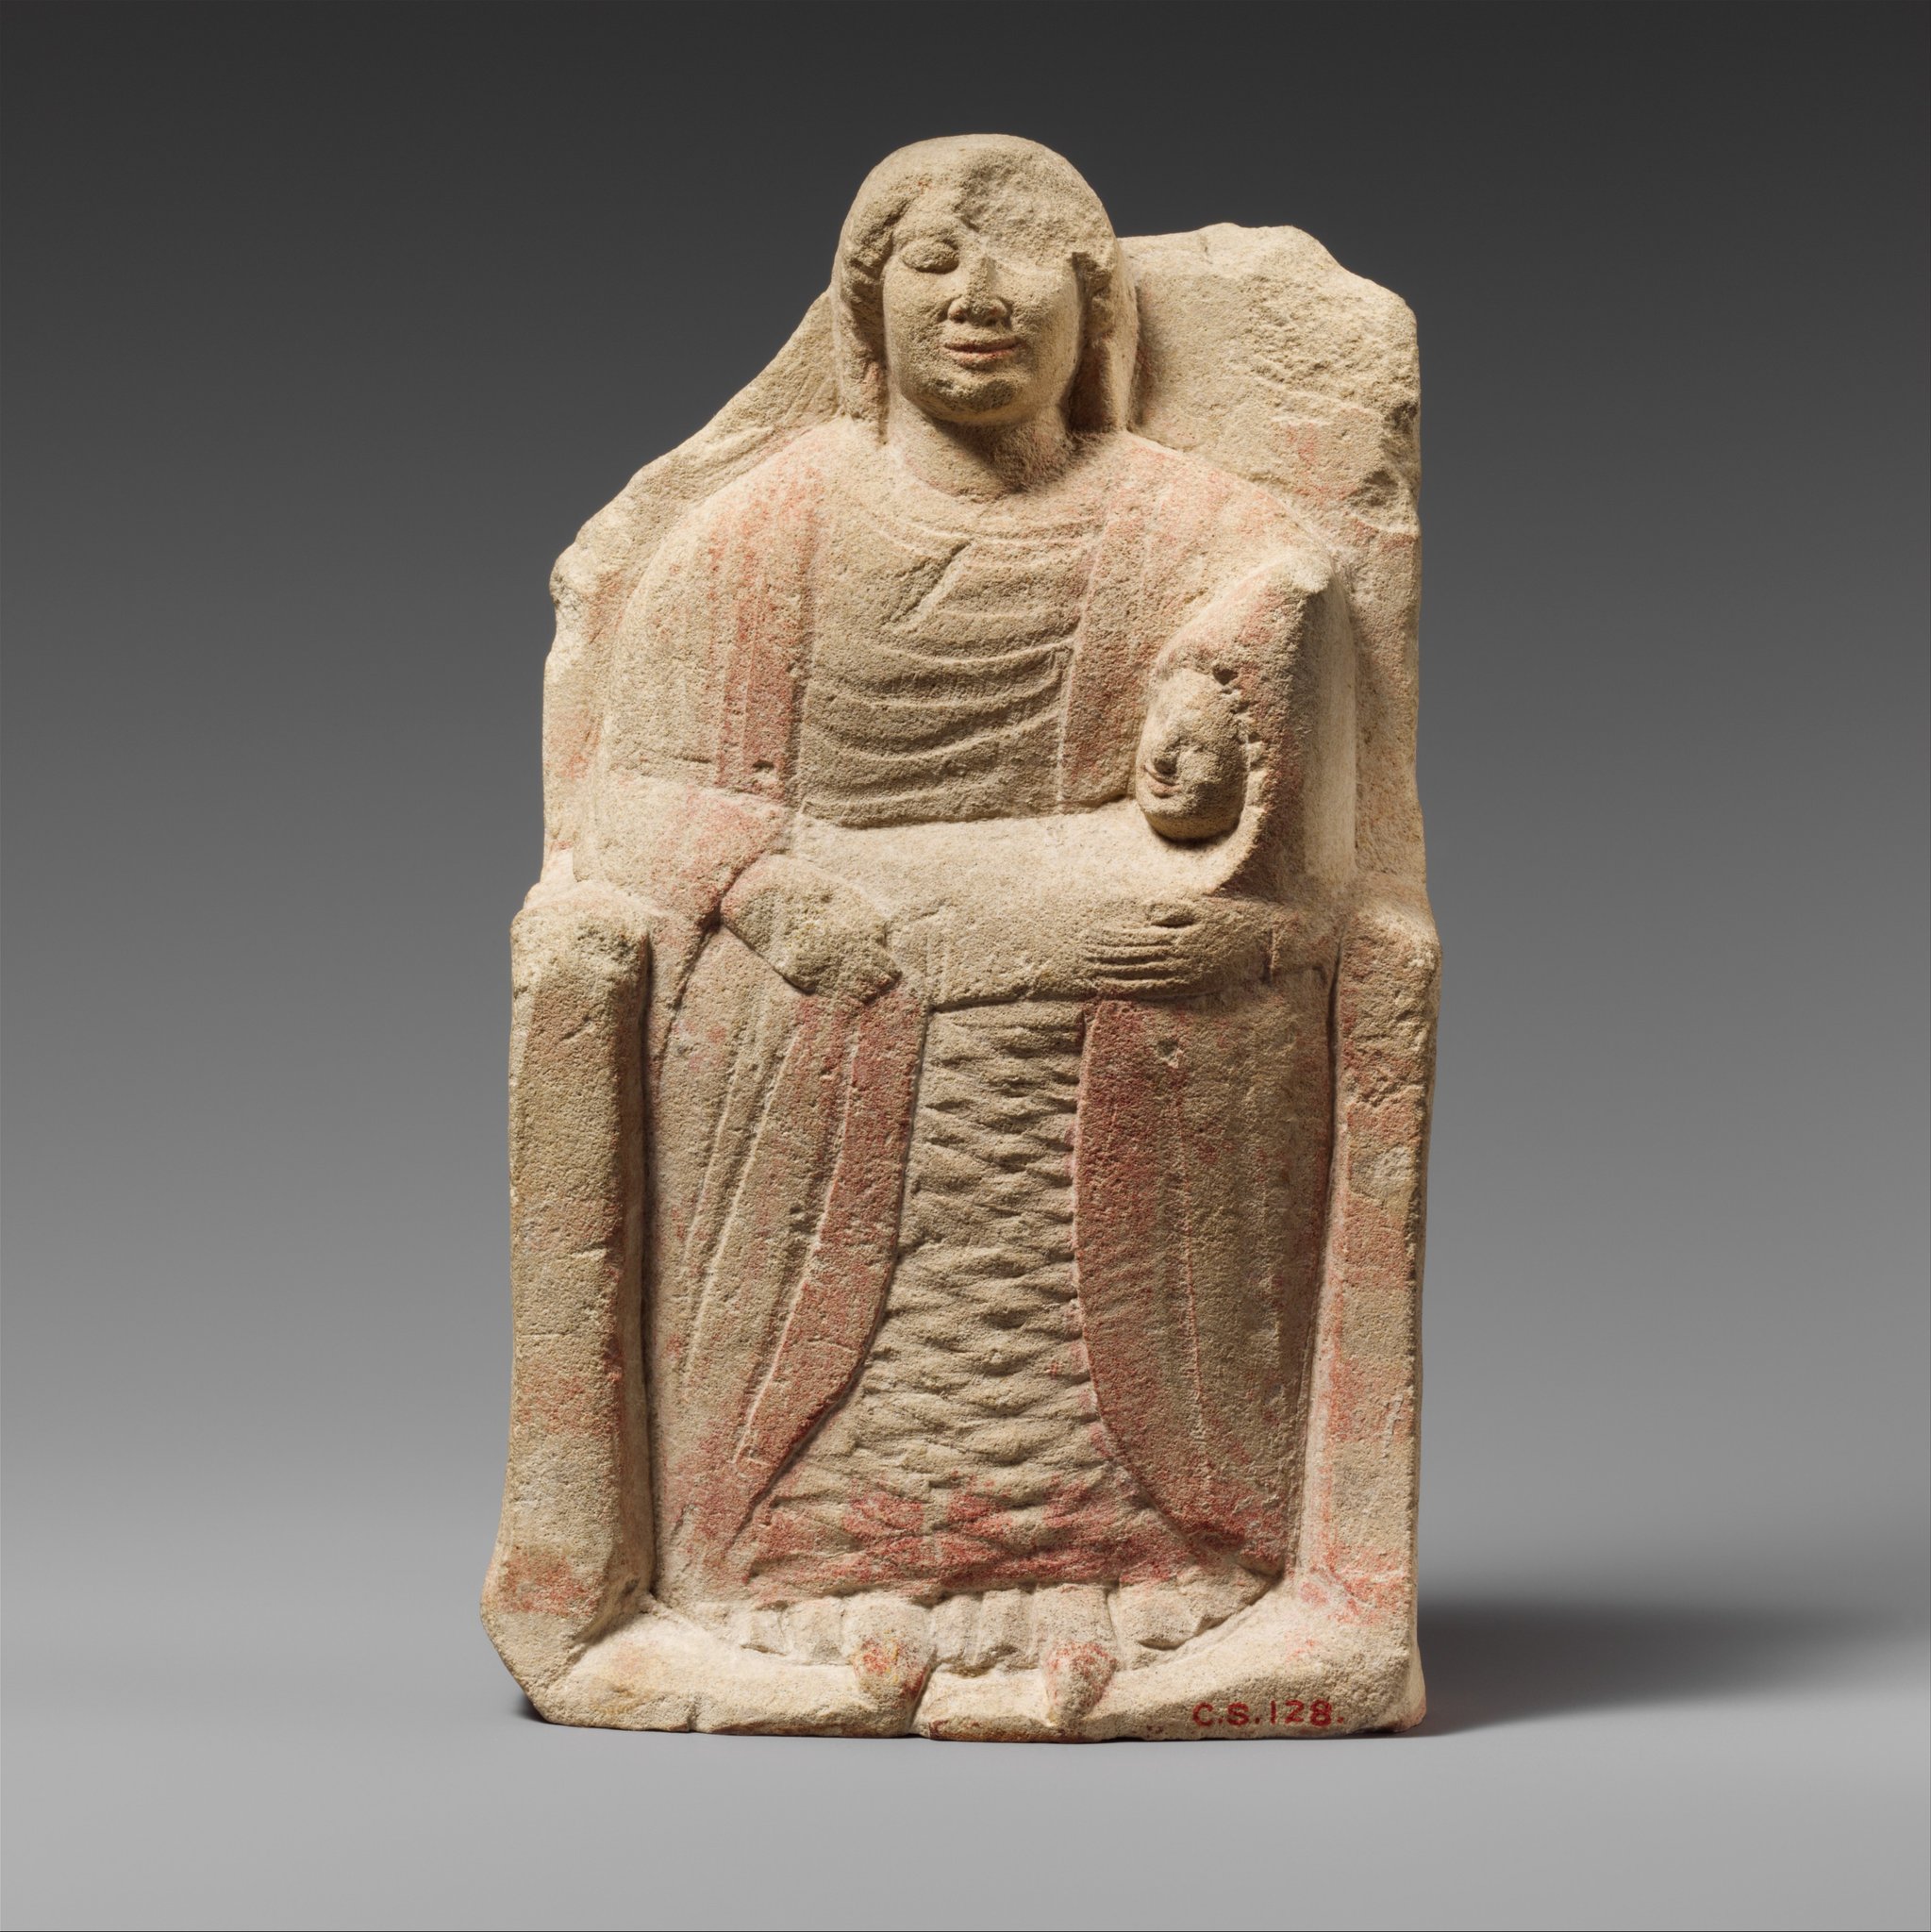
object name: statuette of a woman nursing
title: Seated limestone kourotrophos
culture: cypriot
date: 550-501 BCE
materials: limestone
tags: women